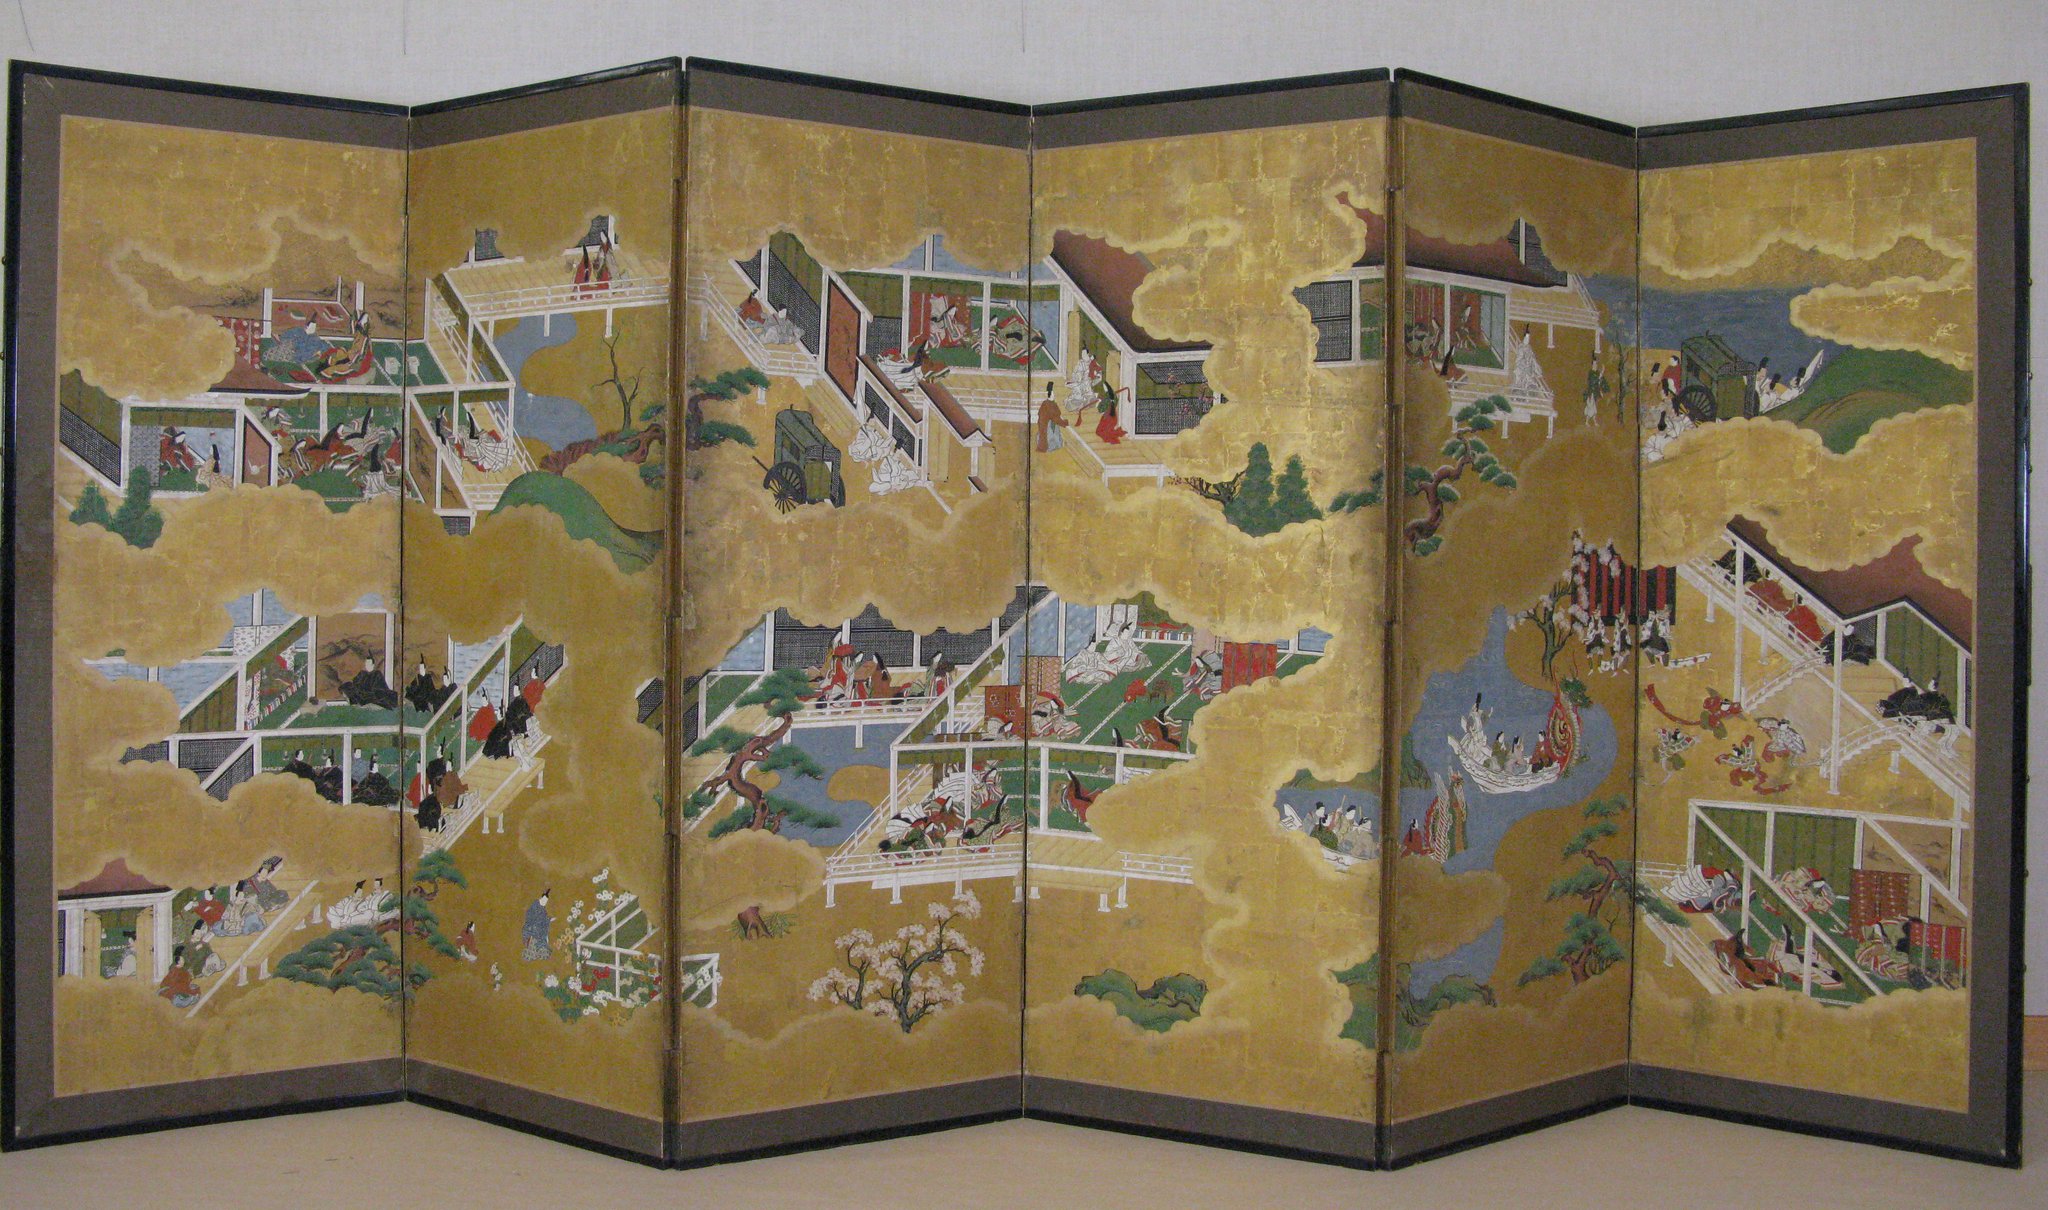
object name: screen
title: Scenes from the Tale of Genji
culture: japanese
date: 1601-1700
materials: gold, ink, panel, paper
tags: human figures,houses,trees,boats